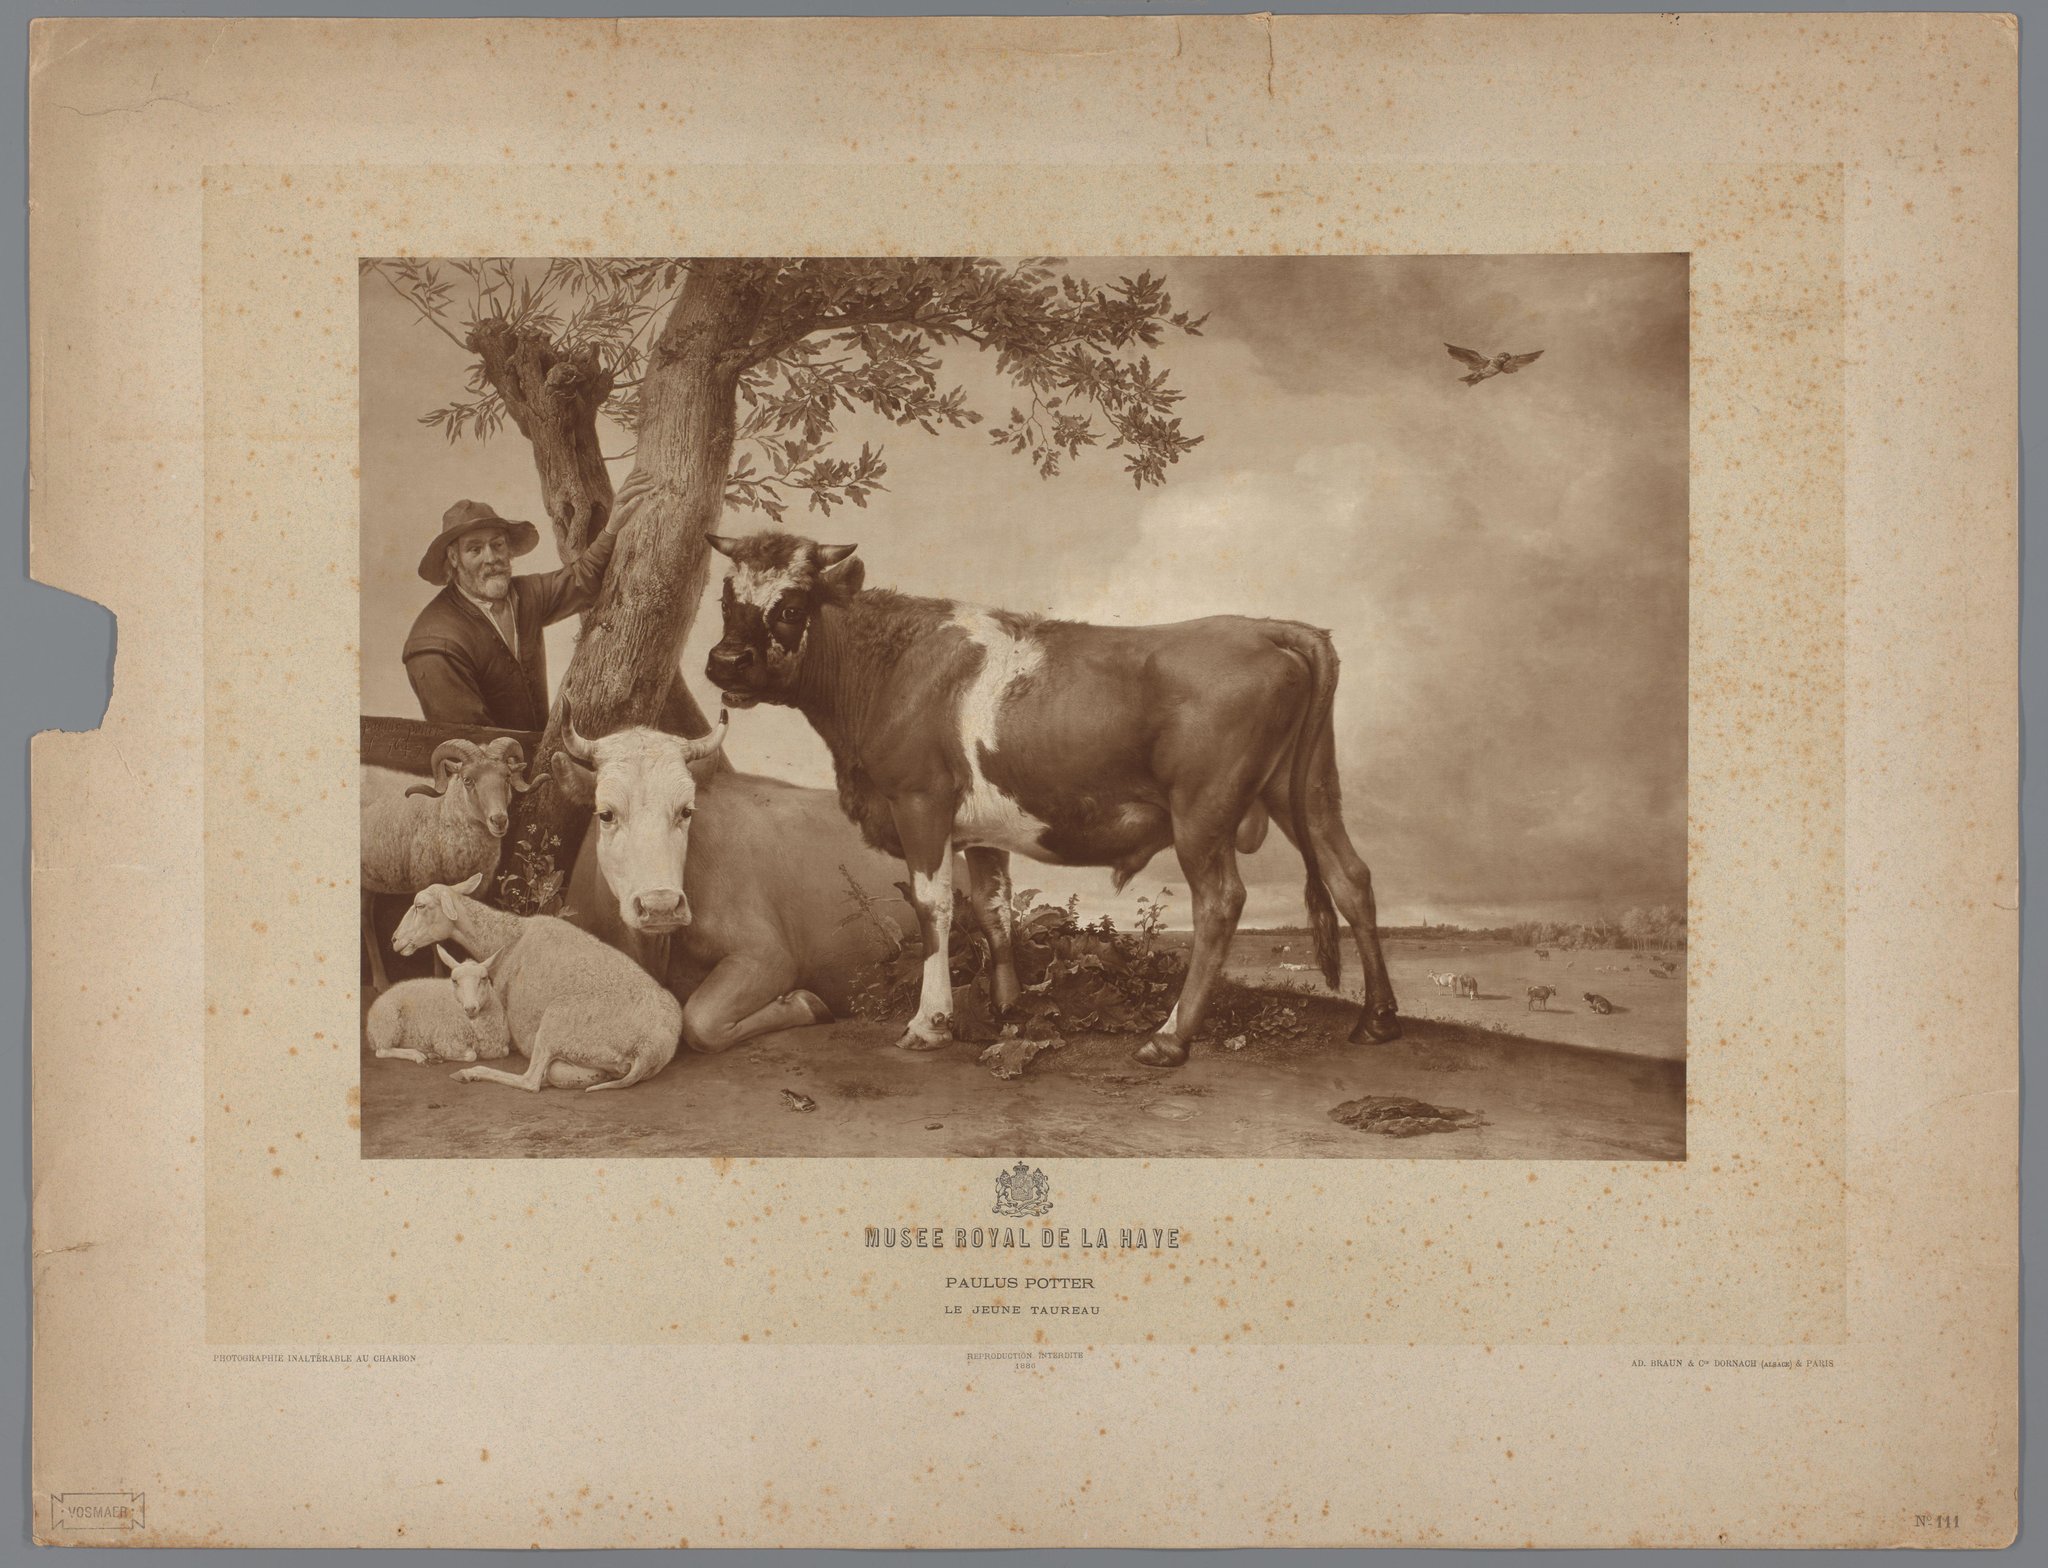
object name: photograph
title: Fotoreproductie van een schilderij van Paulus Potter, 'De [jonge] stier' (coll. Mauritshuis)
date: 1886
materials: cardboard, paper, photographic support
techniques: carbon print